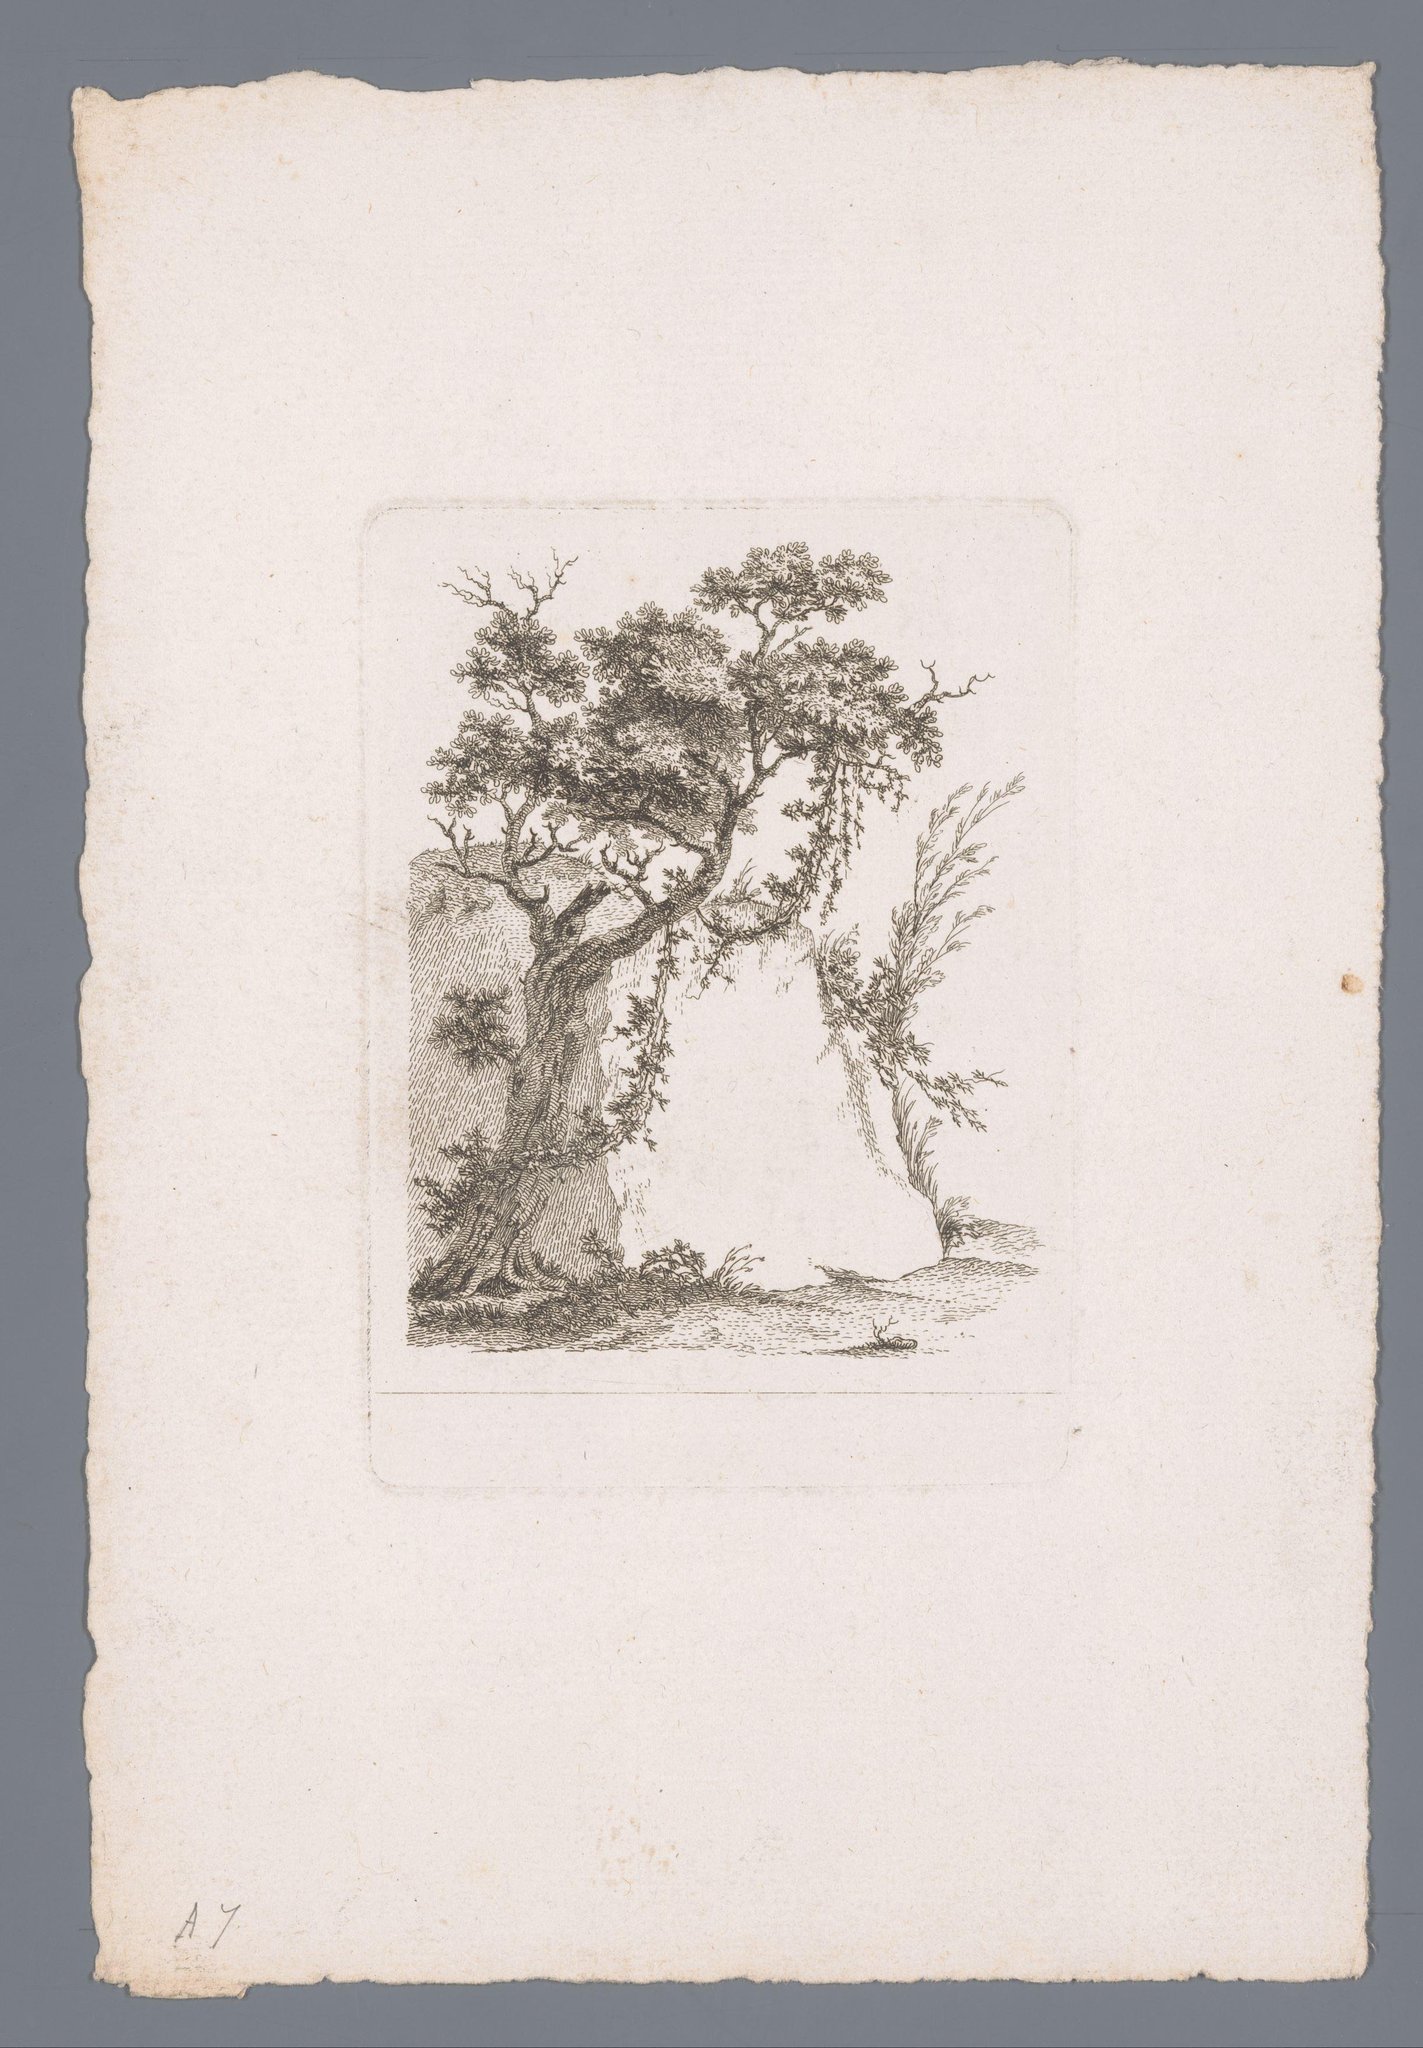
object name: print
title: Hoog rotsblok met een boom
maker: Anonymous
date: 1700-1799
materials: paper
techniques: etching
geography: germany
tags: trees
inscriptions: : ‘Geschenk van J.H. Coster’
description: Mogelijk een titelprent voor een serie, gedrukt voor de letter.